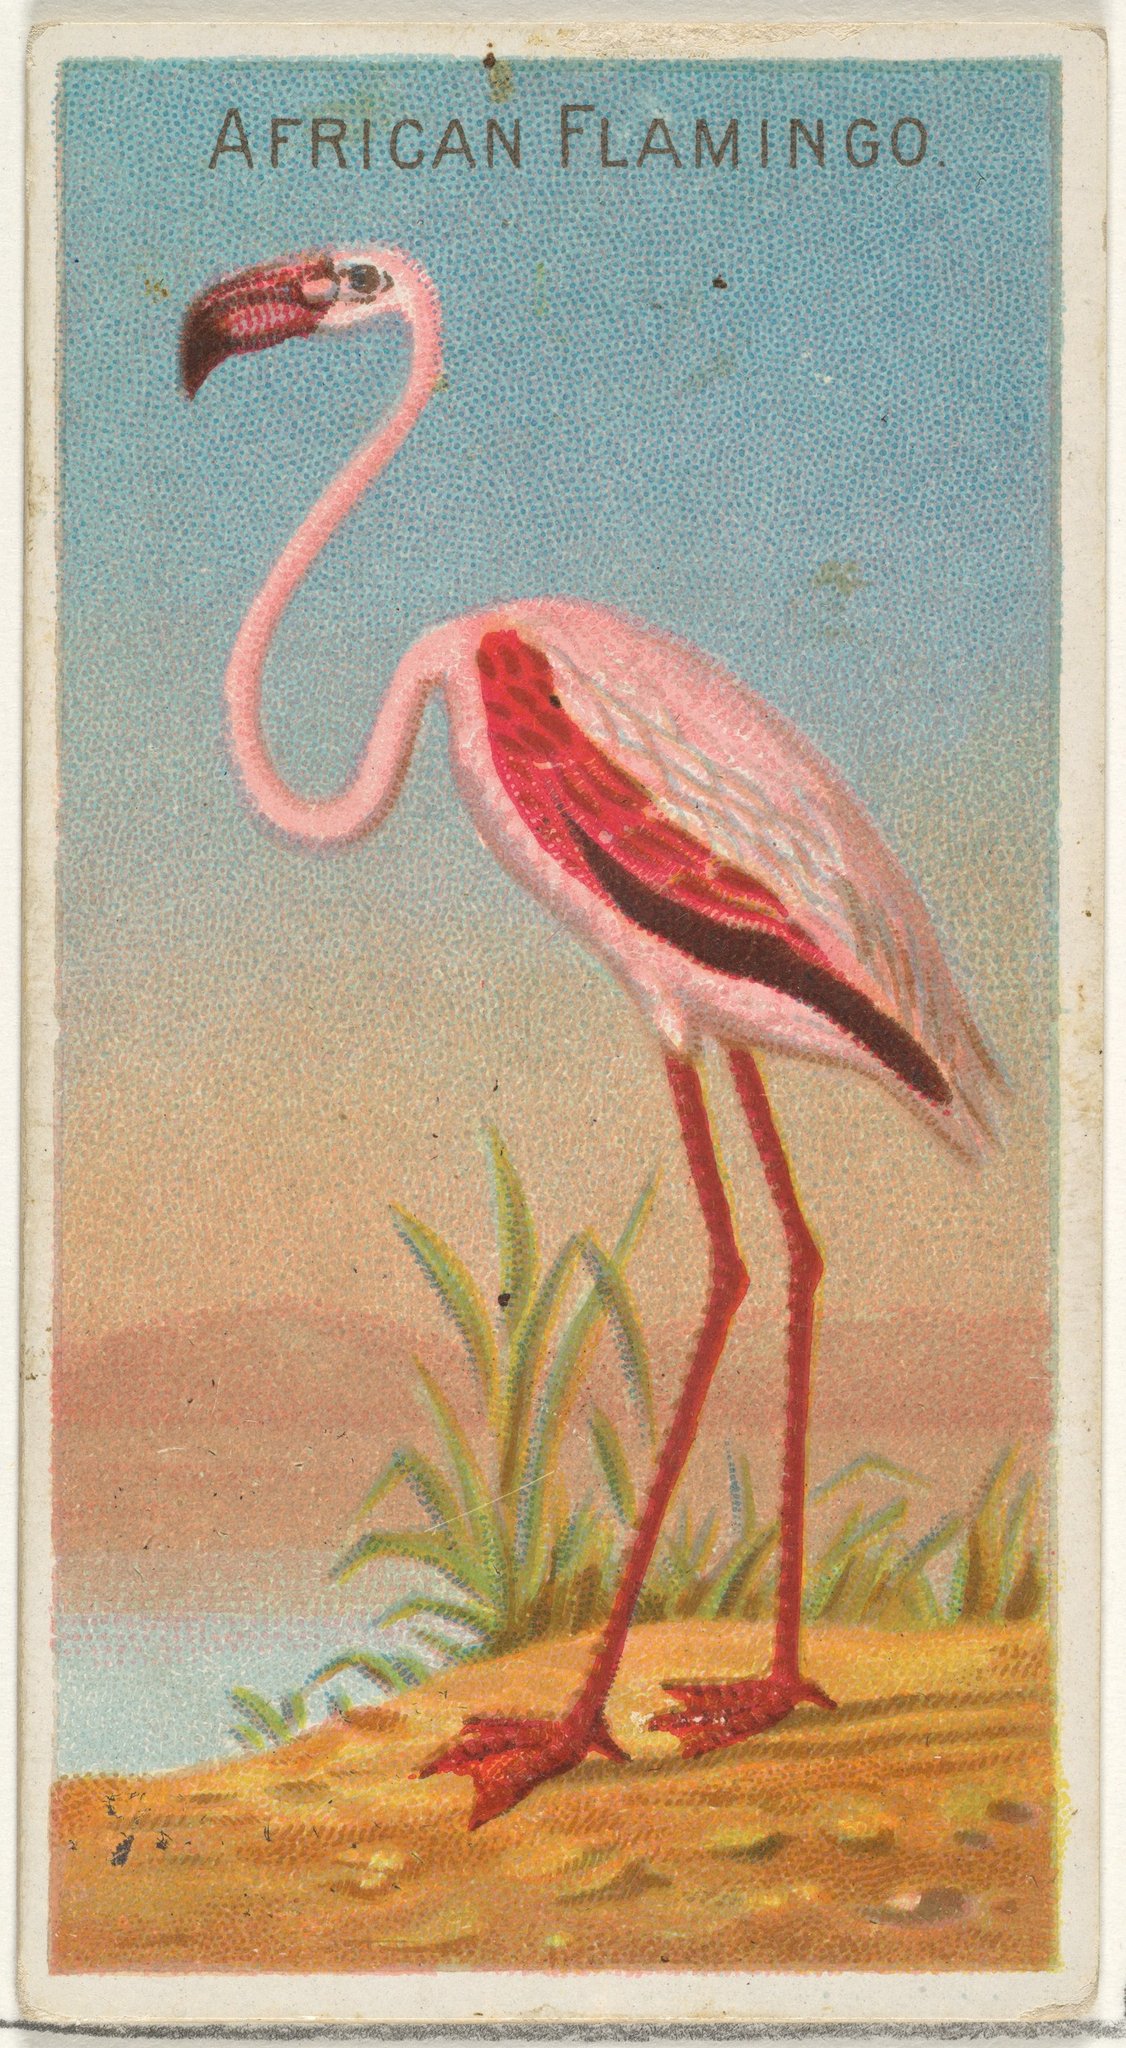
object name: print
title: African Flamingo, from the Birds of the Tropics series (N5) for Allen & Ginter Cigarettes Brands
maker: allen & ginter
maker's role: publisher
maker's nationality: american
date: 1889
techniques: color lithograph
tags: birds